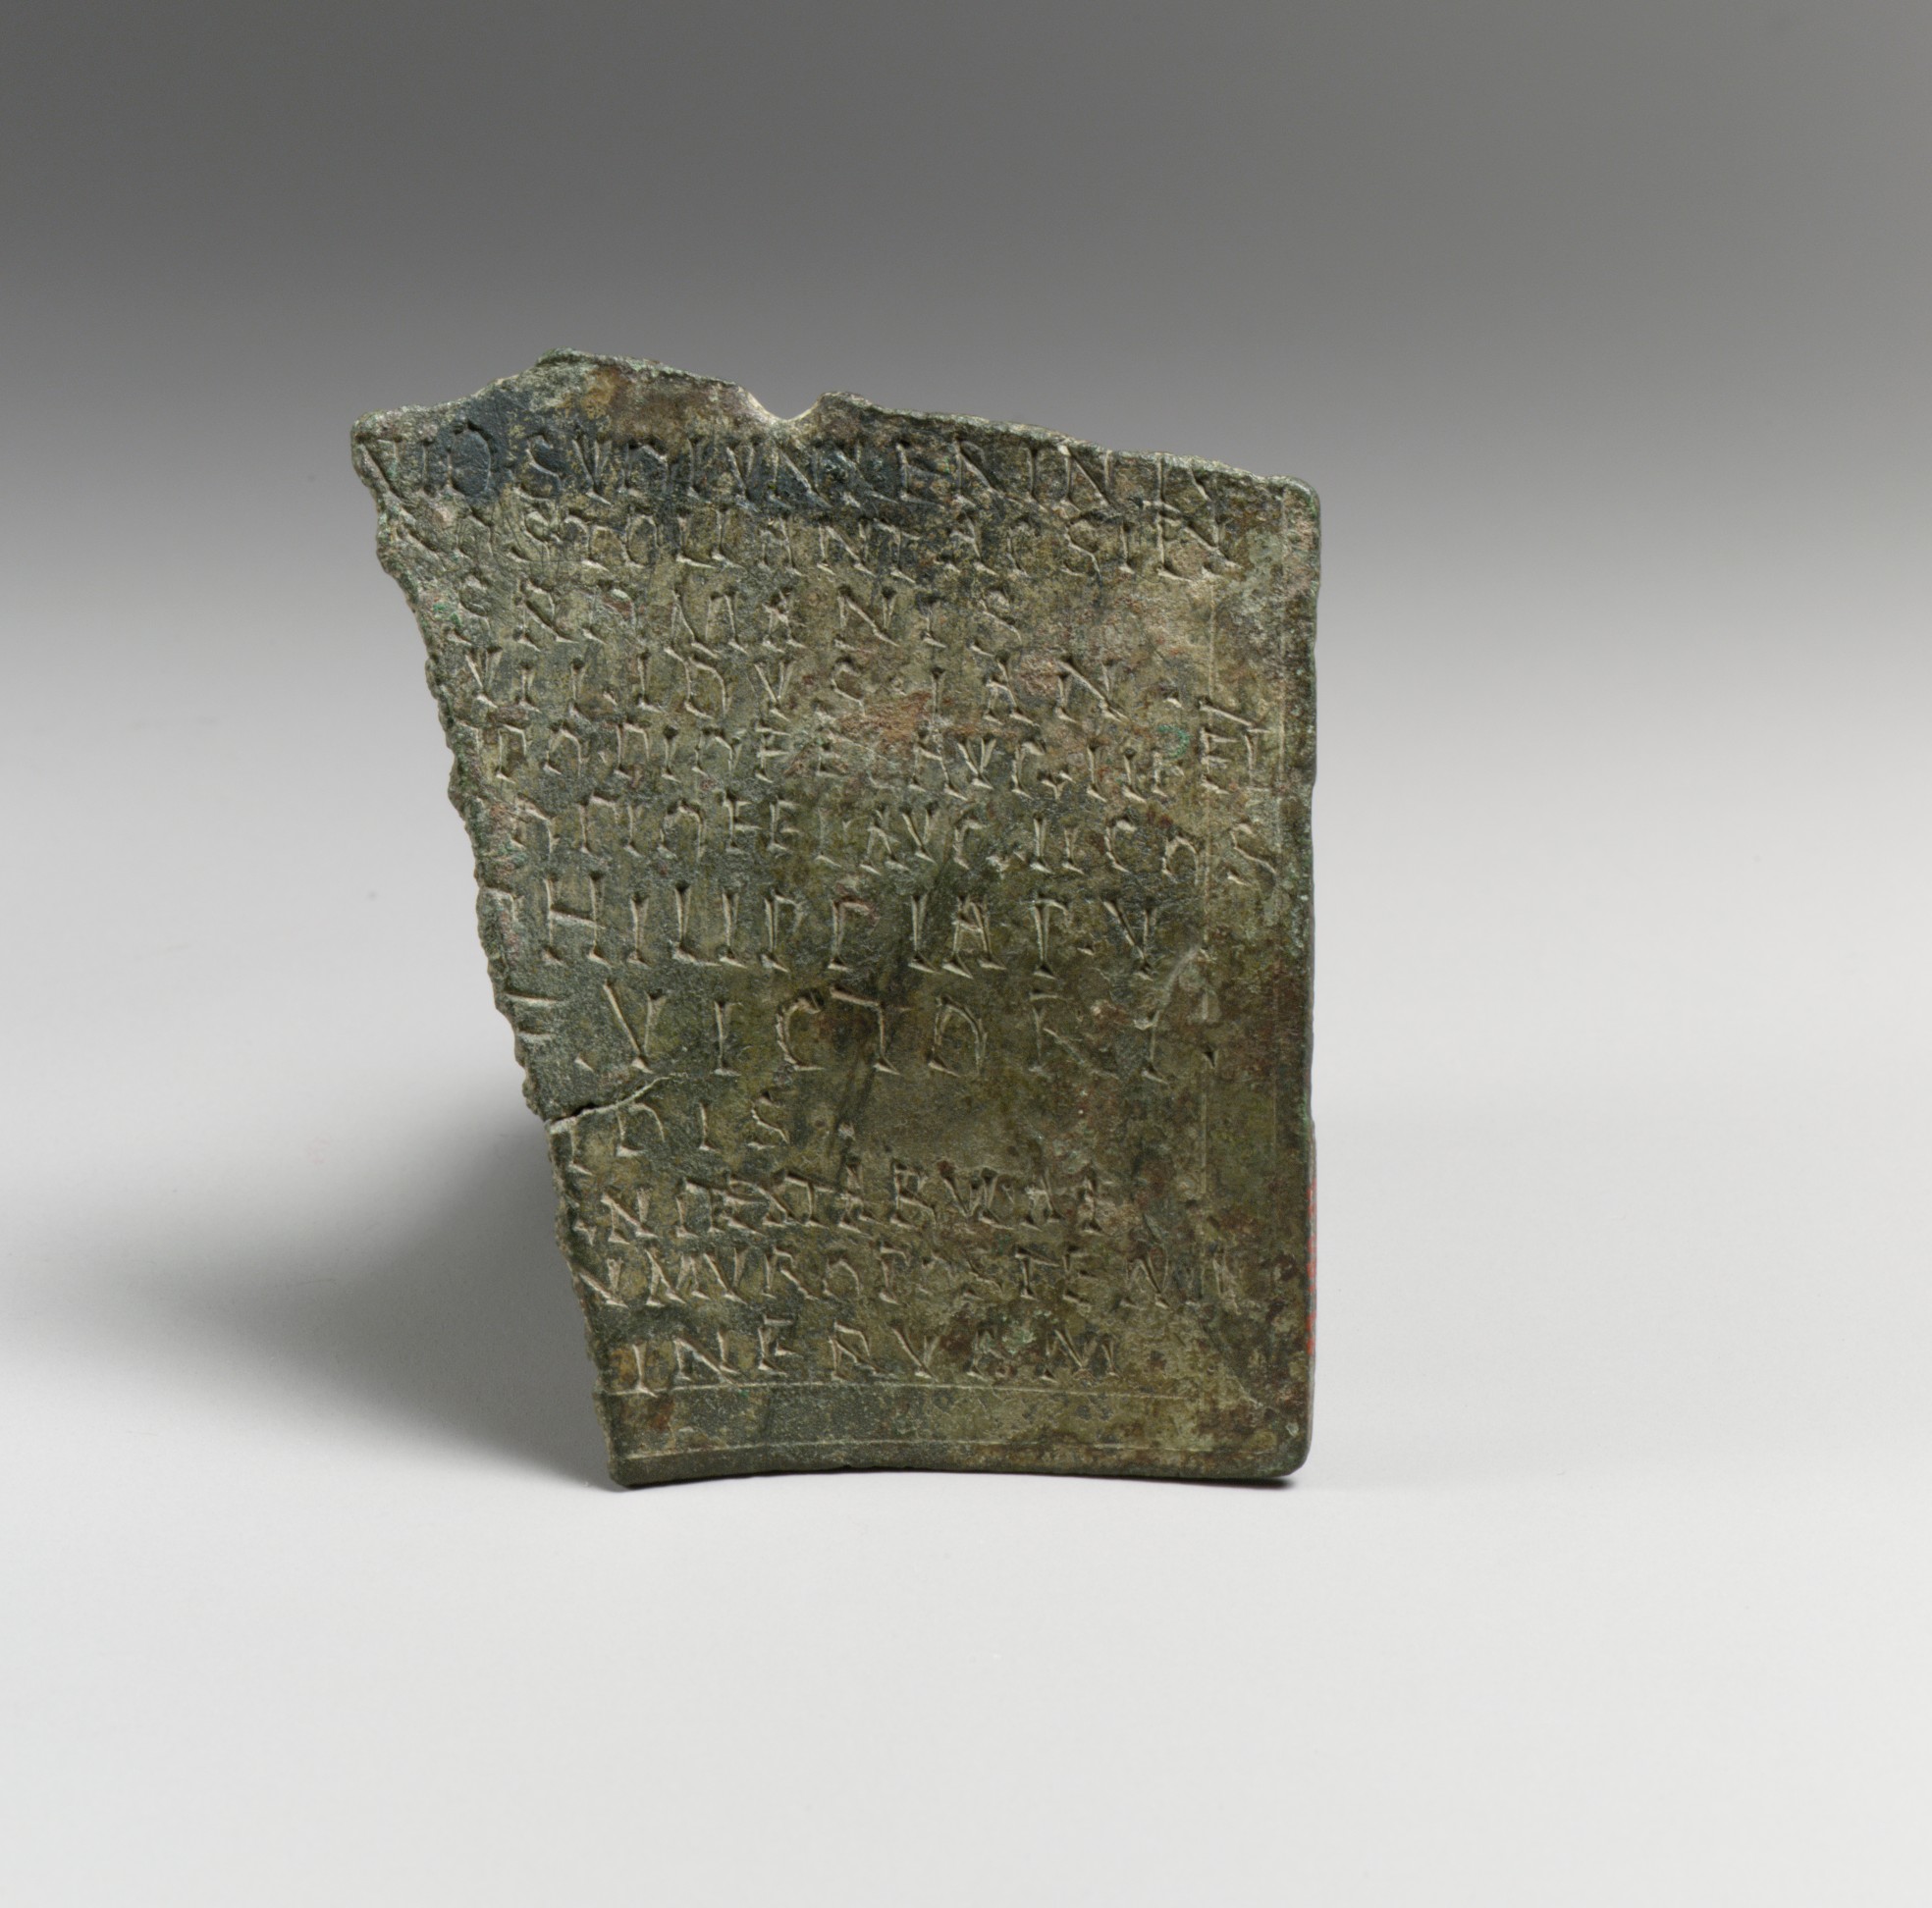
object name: military diploma fragment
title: Bronze military diploma fragment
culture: roman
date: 248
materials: bronze